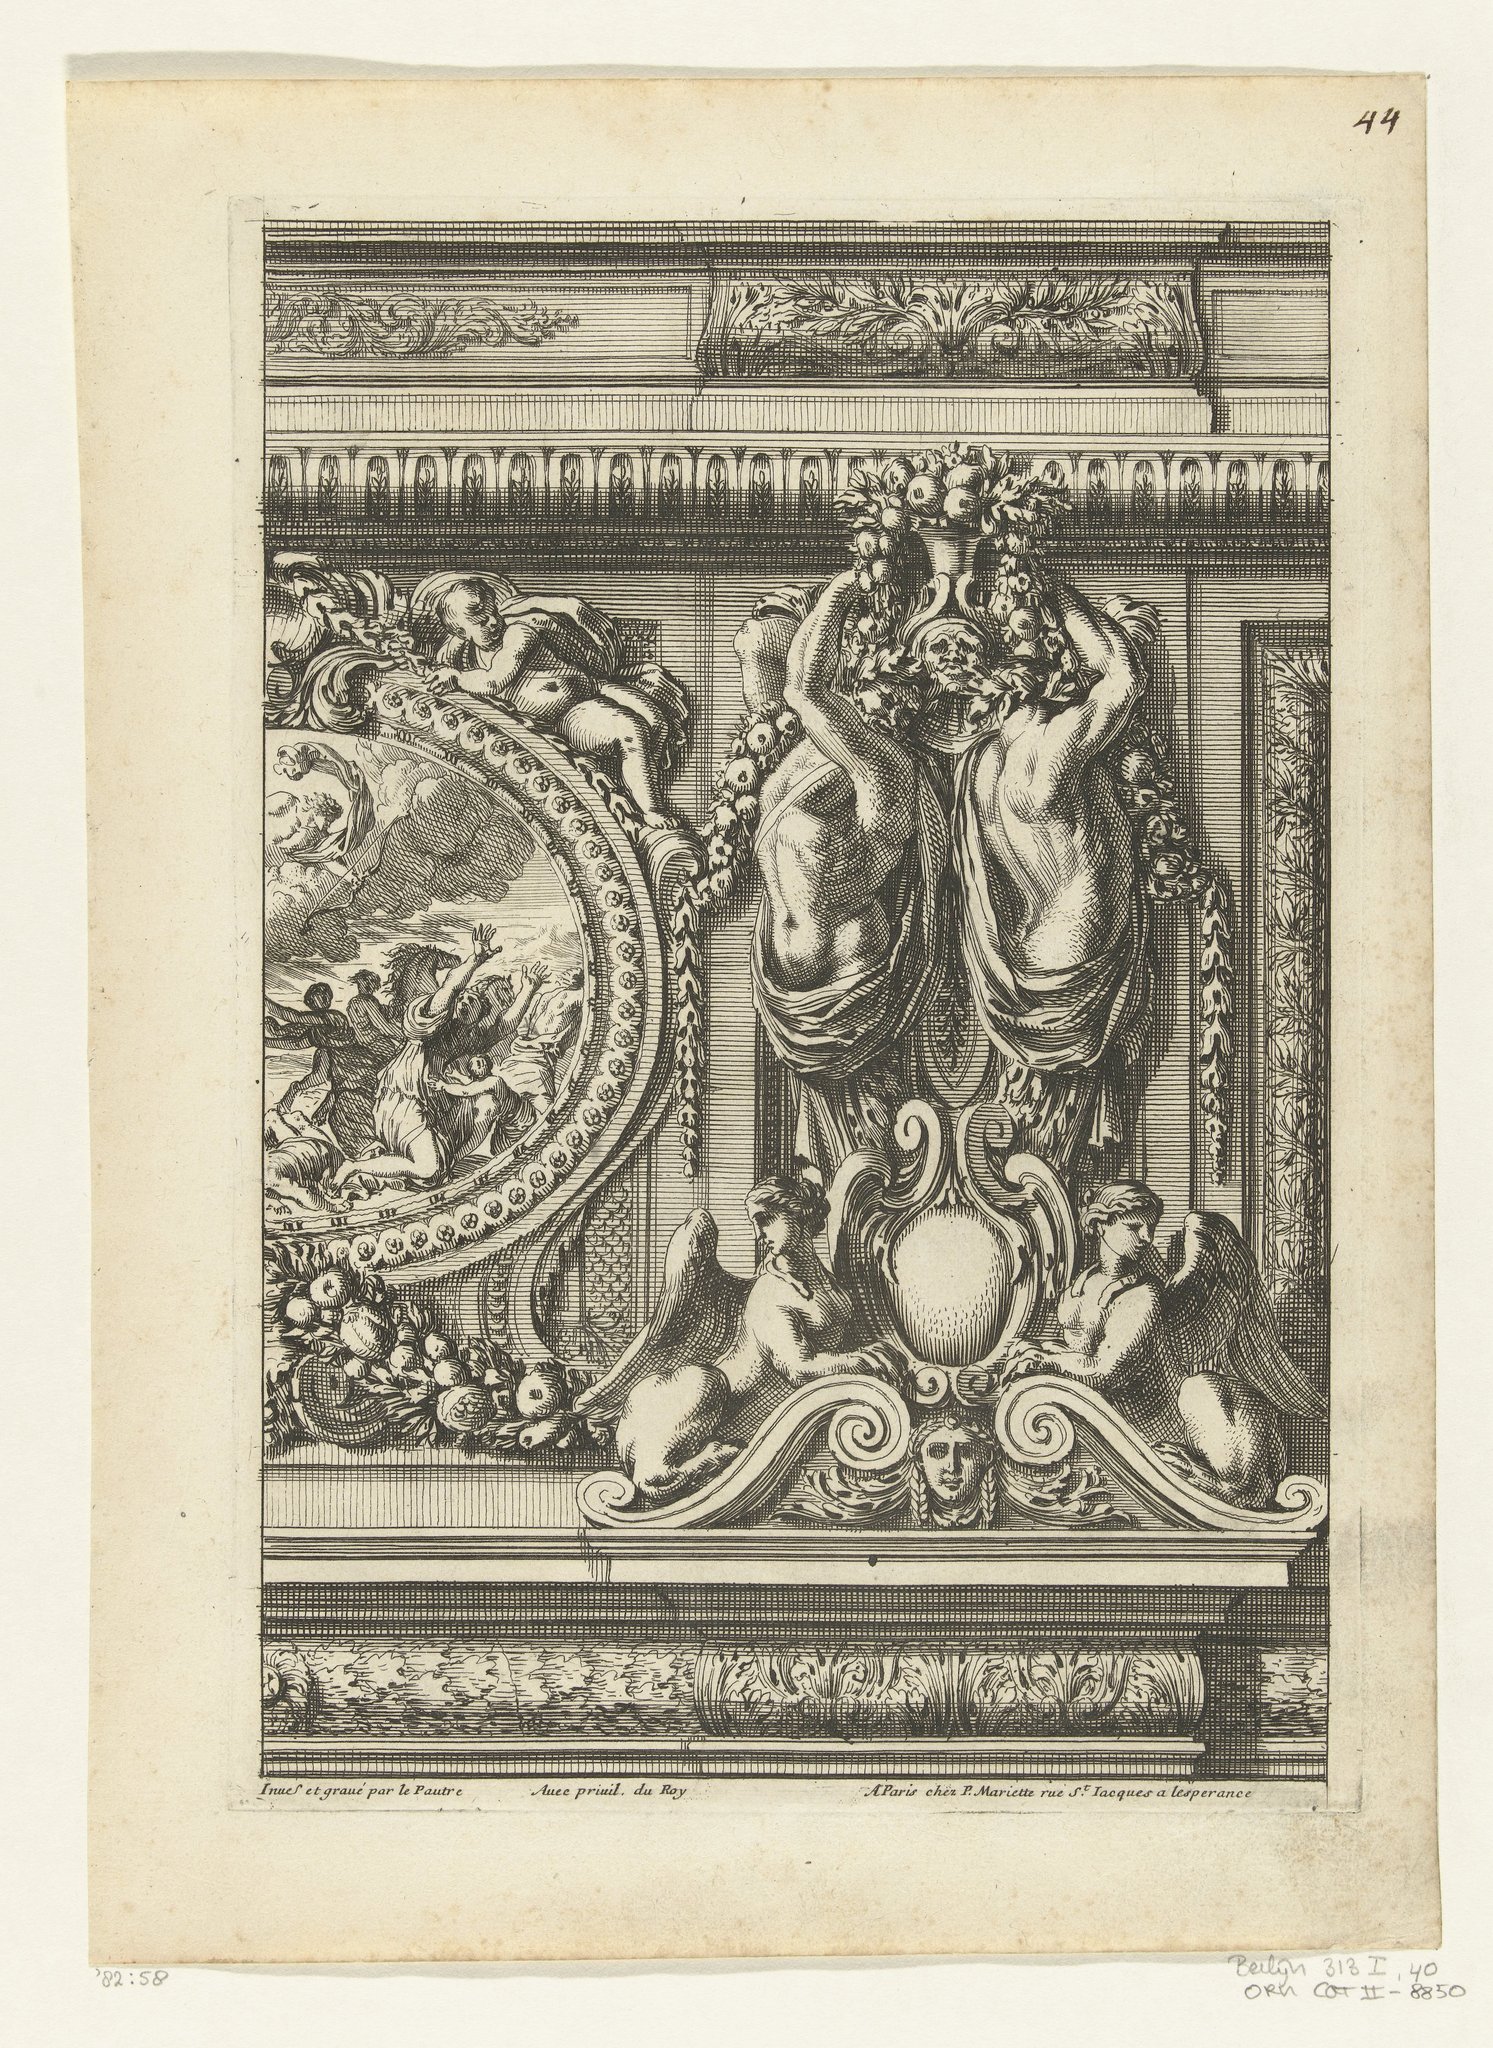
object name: ornament print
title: Angle de Plafons de gallerie, et autres ornemens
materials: paper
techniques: etching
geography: france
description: Aan de rechterkant staan twee hermen boven twee sfinxen aan weerszijden van een medaillon, aan de linkerkant een half ovaal medaillon met Apollo die de Niobiden doodt. Uit serie van 6 ongenummerde bladen.